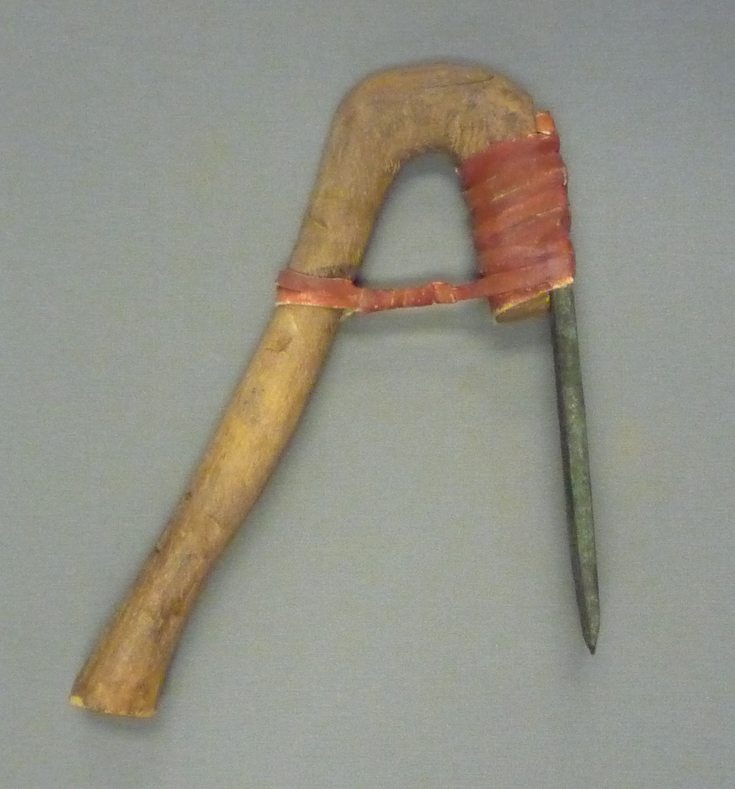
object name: adze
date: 1479-1458 BCE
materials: bronze, copper alloy, leather, wood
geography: egypt